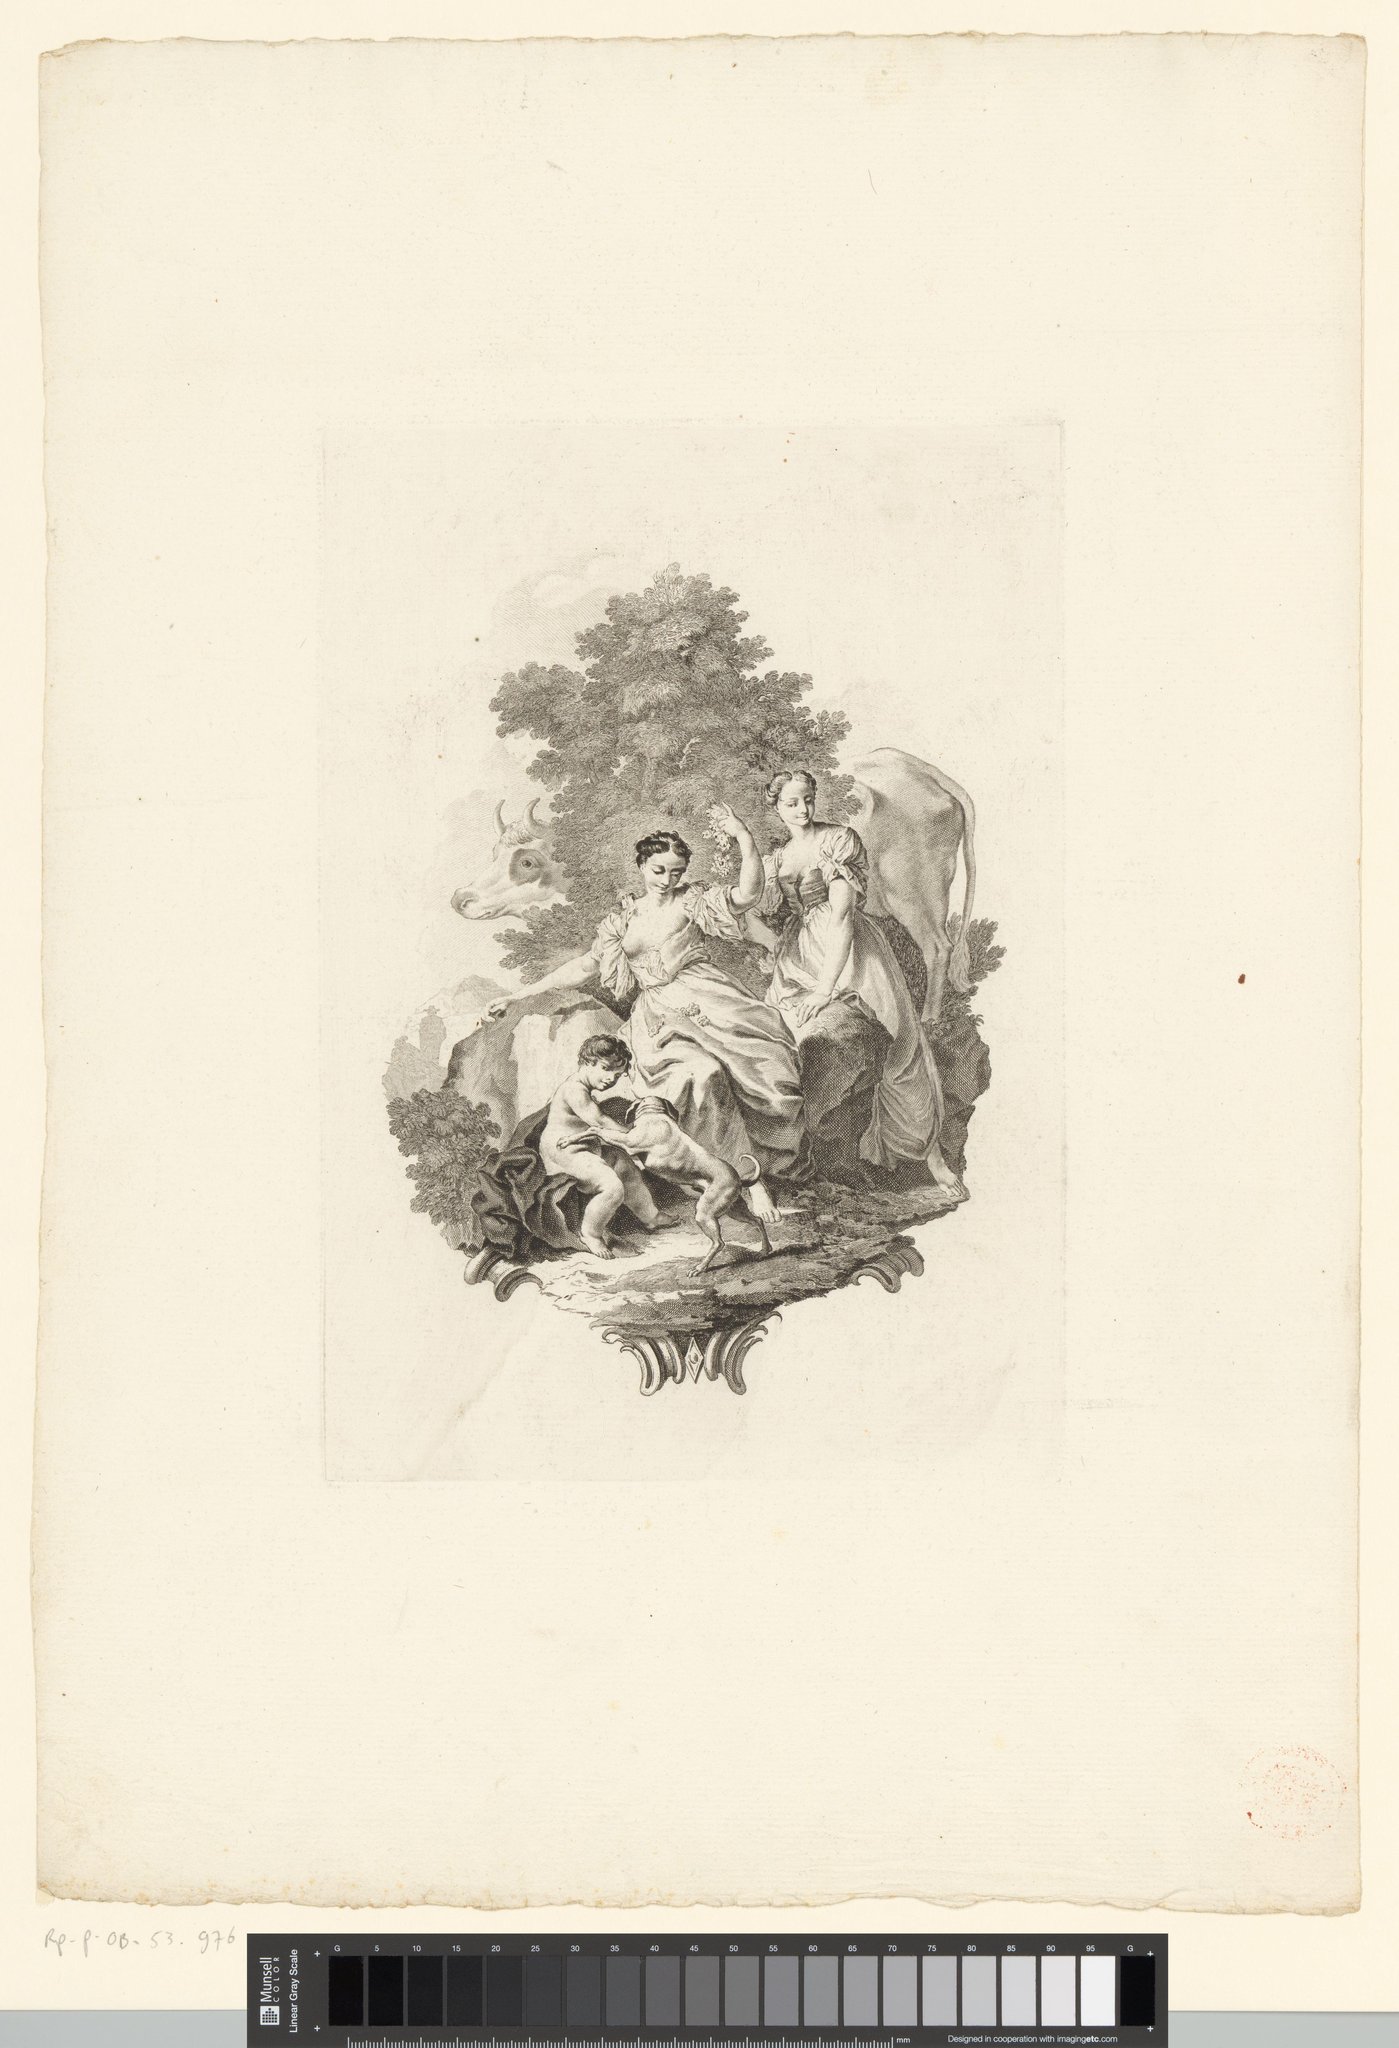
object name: print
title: Twee vrouwen en een naakte jongen spelend met een hond en een stier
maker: martin schedel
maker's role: print maker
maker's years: 1677-1748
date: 1687-1748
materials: paper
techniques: etching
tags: adolescent, young woman, maiden, cow, dog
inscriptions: collector's mark: Lugt 240